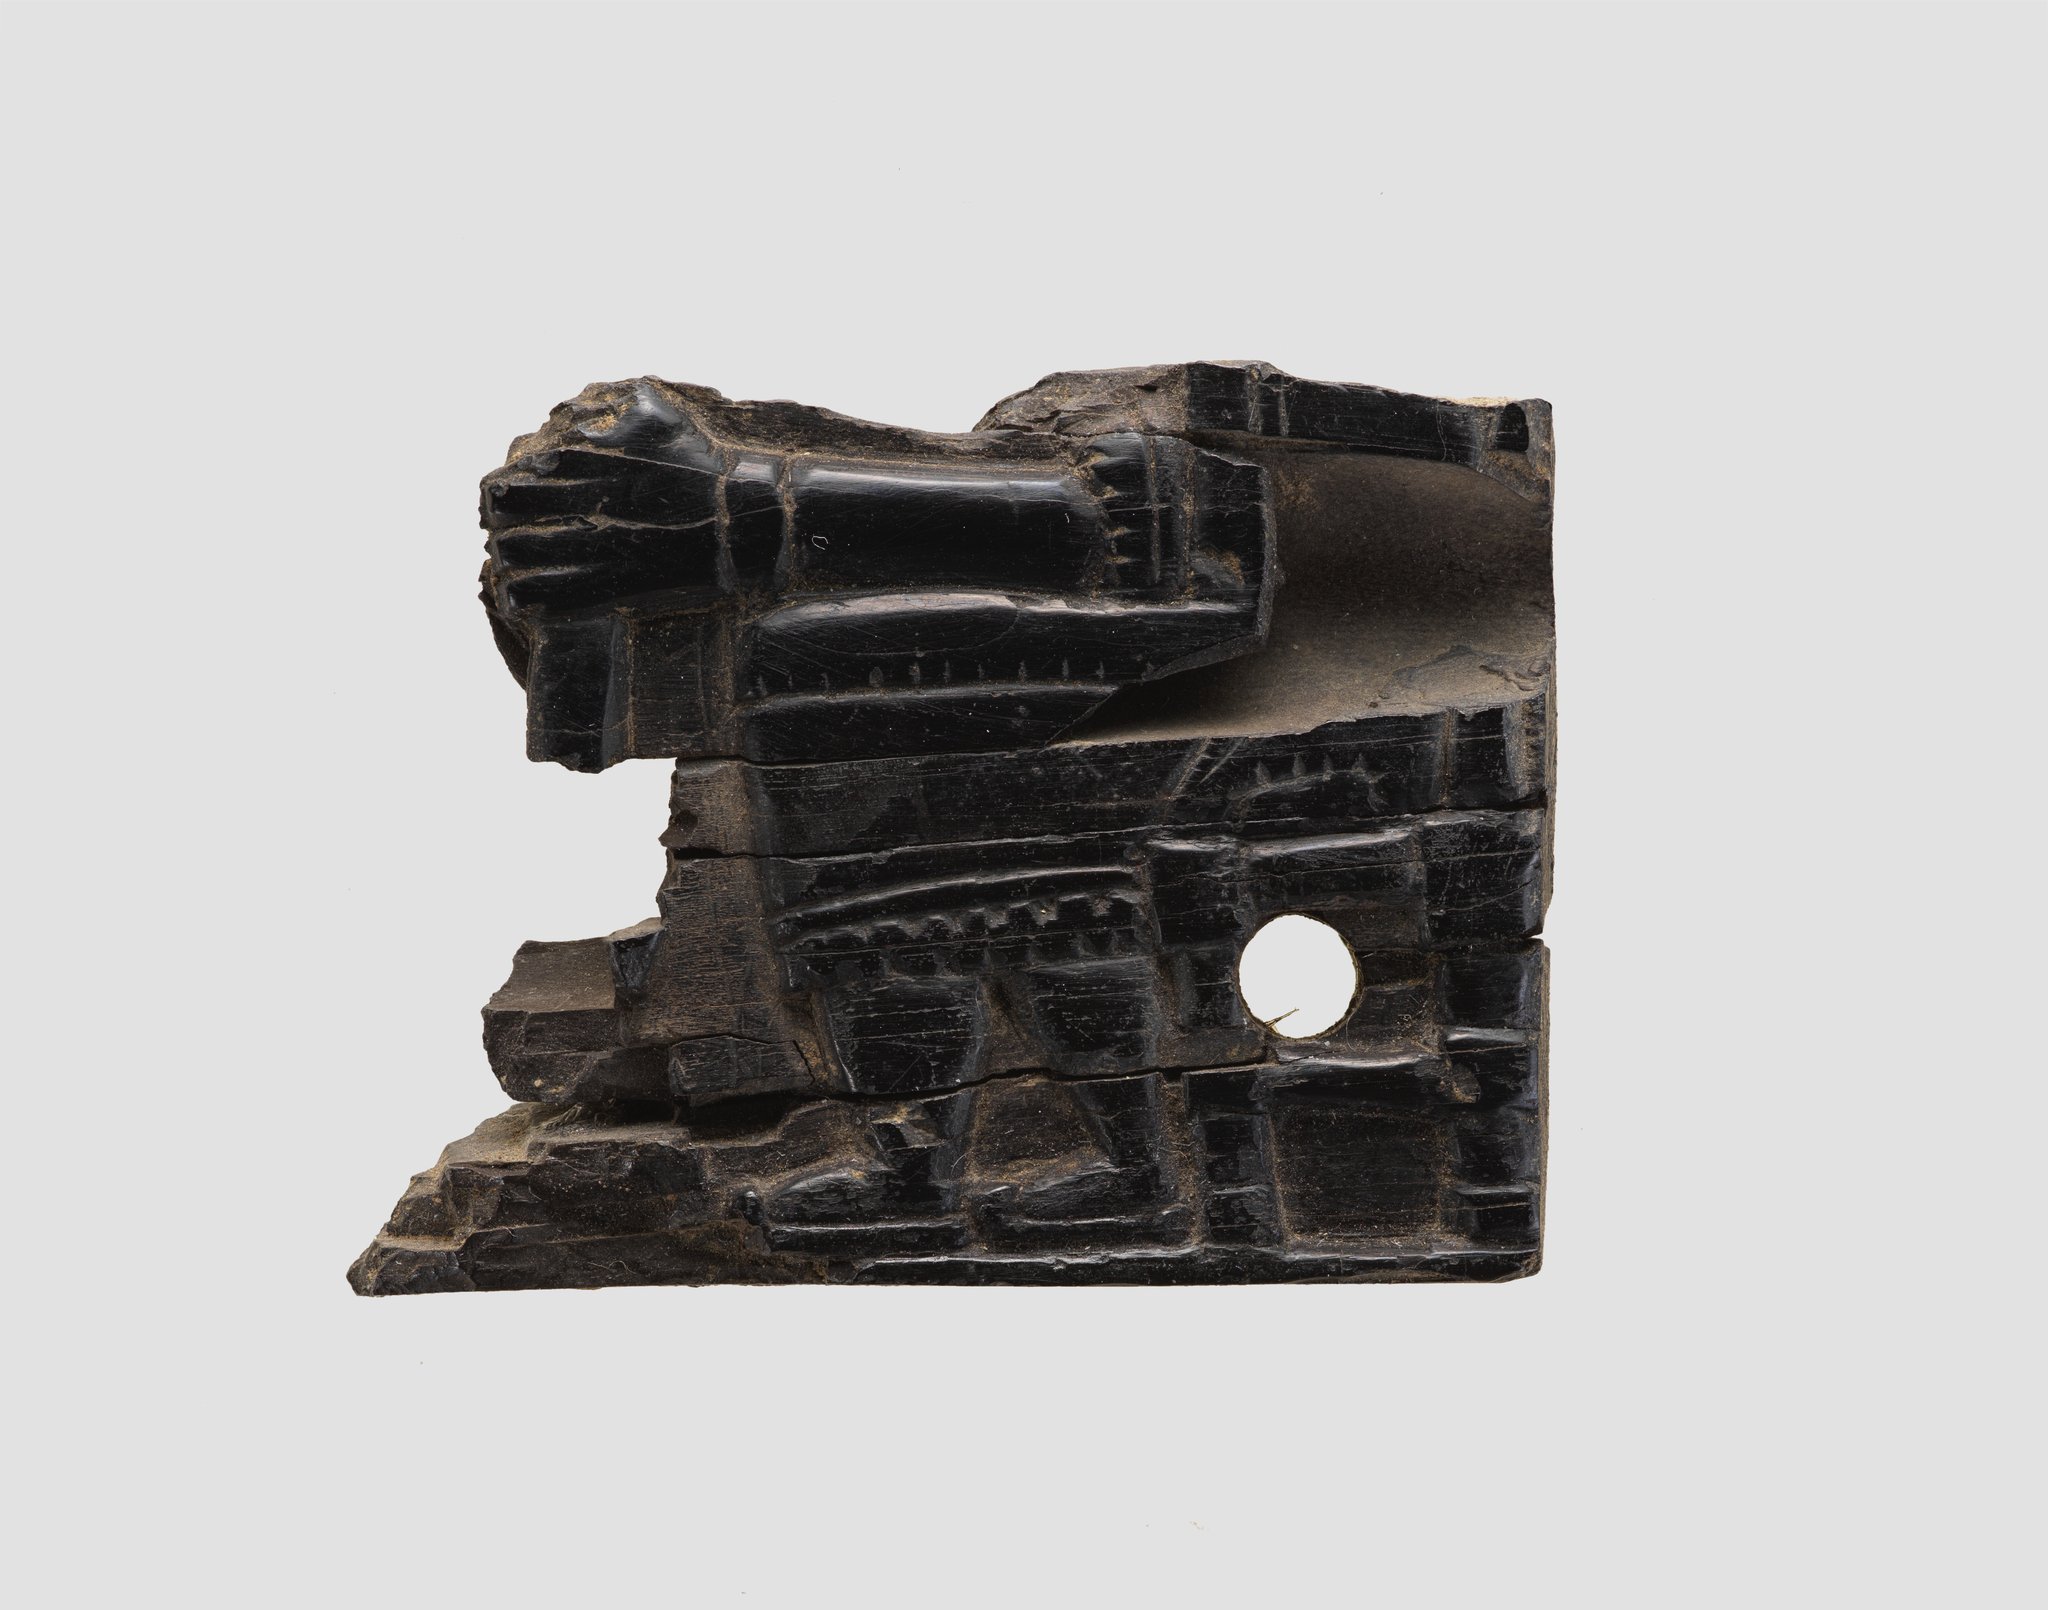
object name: relief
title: Plaque fragment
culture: iranian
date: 900-801 BCE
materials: ivory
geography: iran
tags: feet,hands